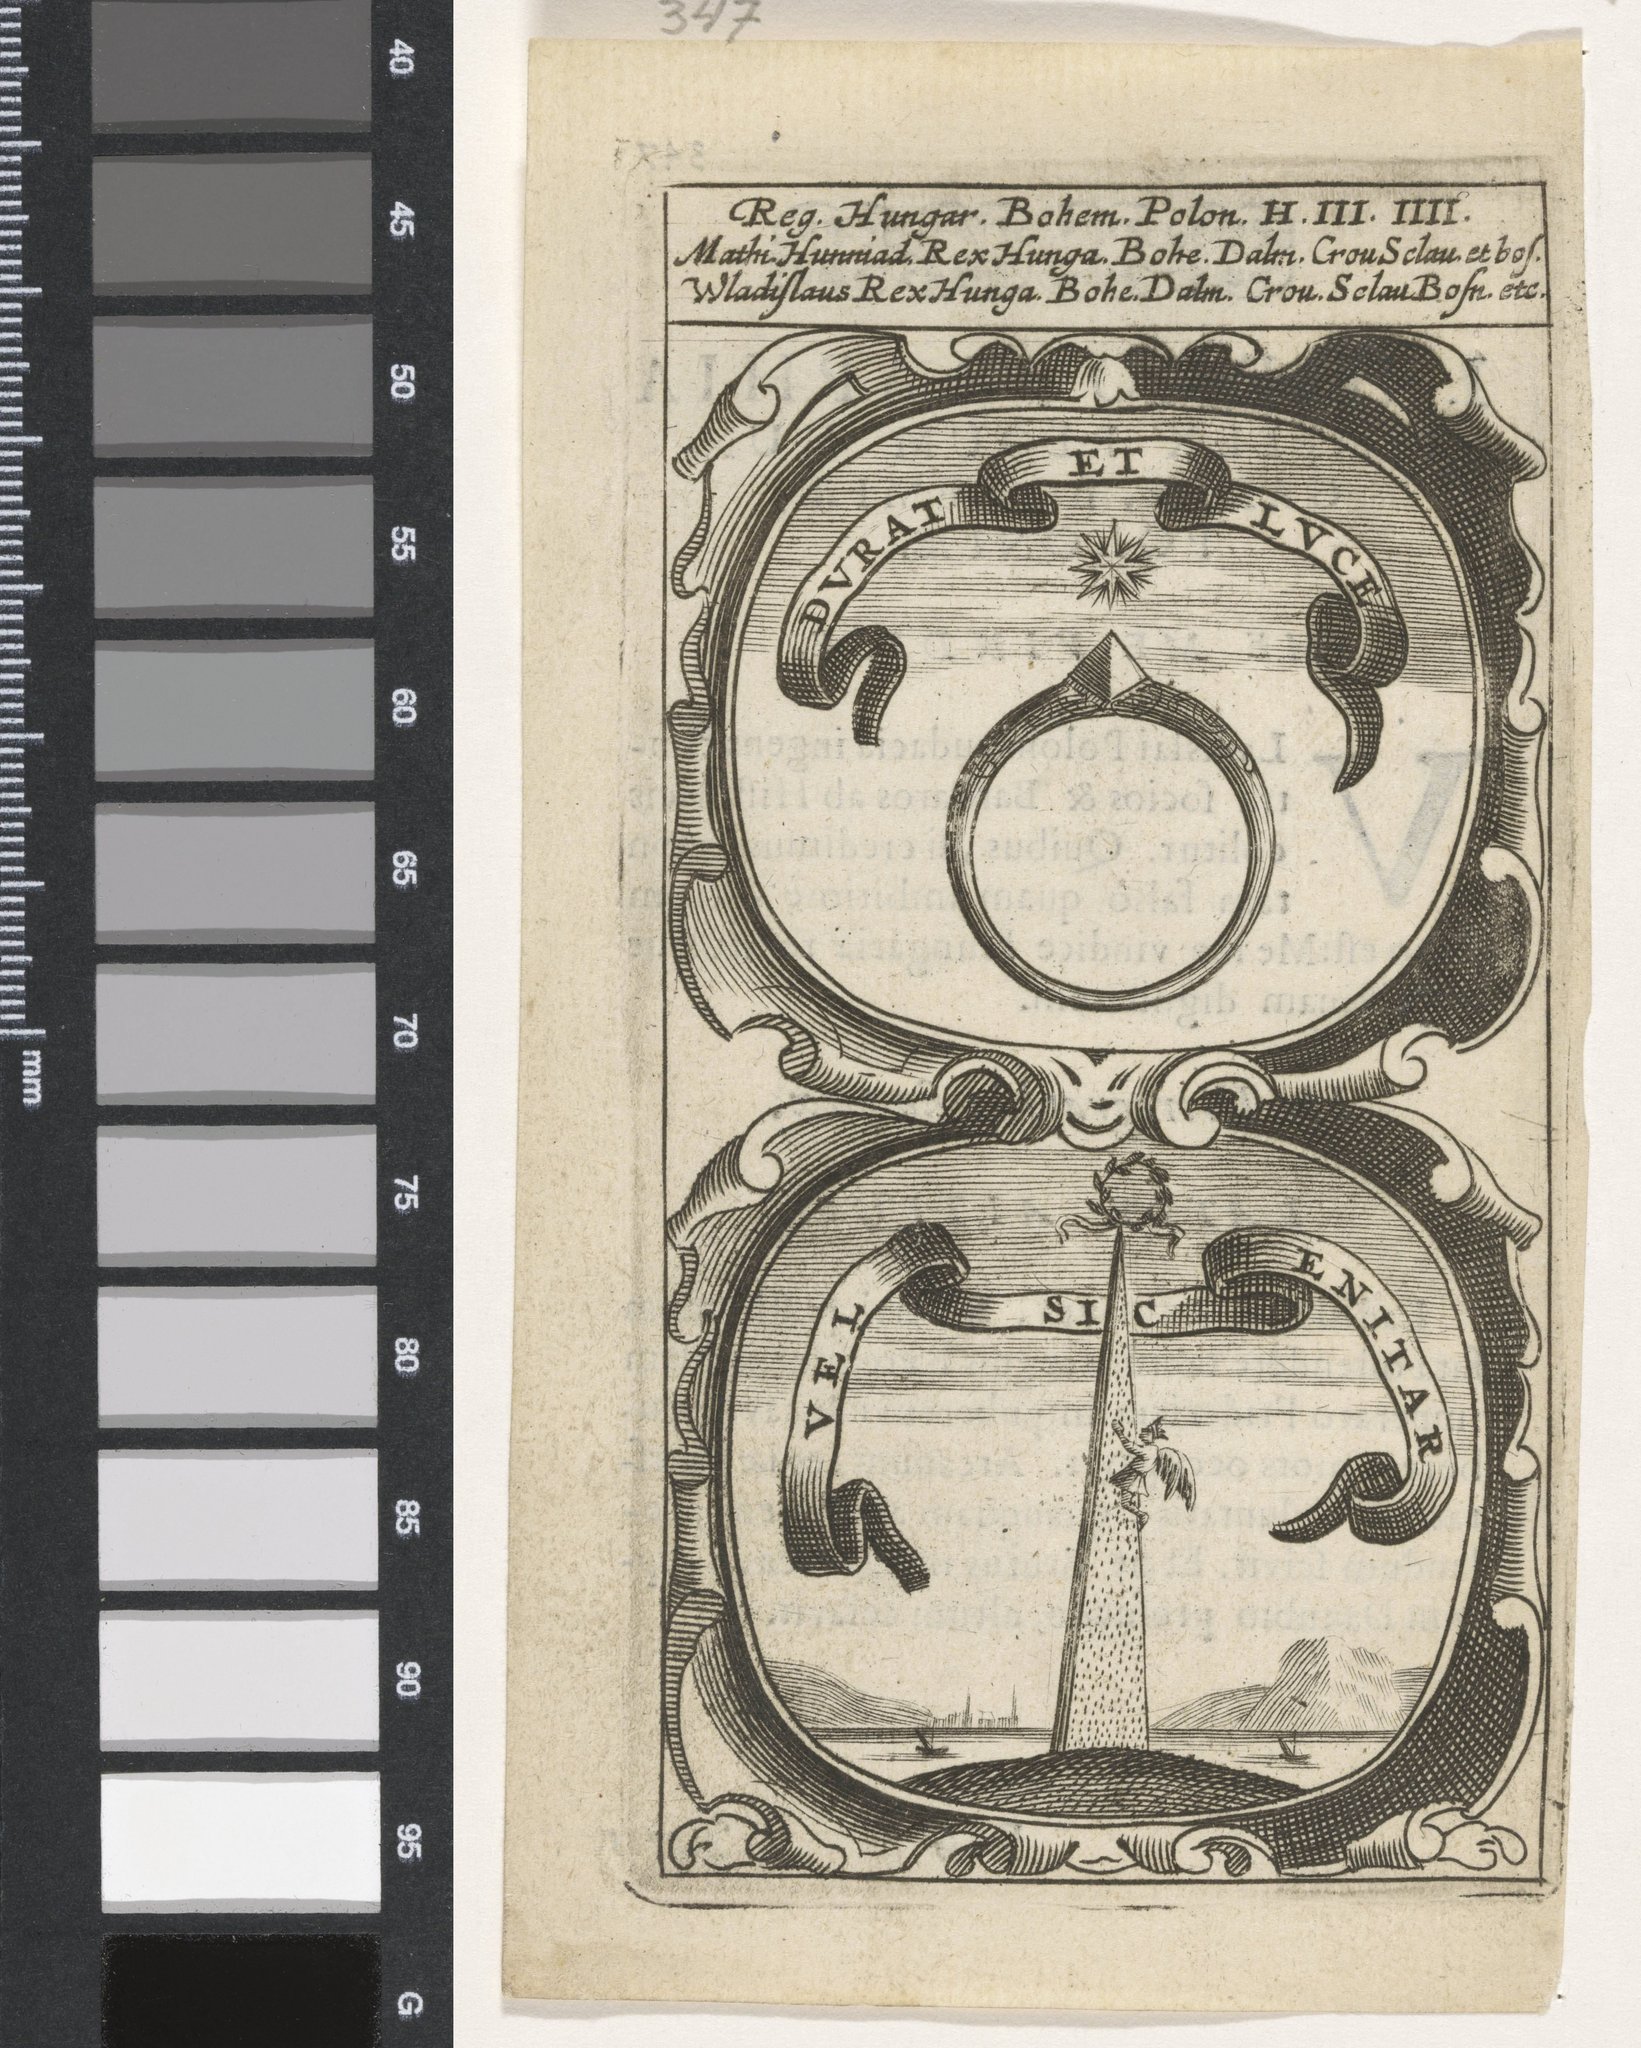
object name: book illustration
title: Symbola Divina et Humana Pontificum Imperatorum Regum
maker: Anonymous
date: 1666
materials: paper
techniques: engraving, letterpress printing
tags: vienna, climbing, obelisk, needle, garland, wreath, ring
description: Een embleem met twee voorstellingen. Boven een ring met daarboven een ster. Onder een landschap met een obelisk waarin iemand met vleugels naar boven klimt. Op de obelisk een lauwerkrans. Het betreffen deviezen van Matthias Corvinus en Wladislaus II van Hongarije.